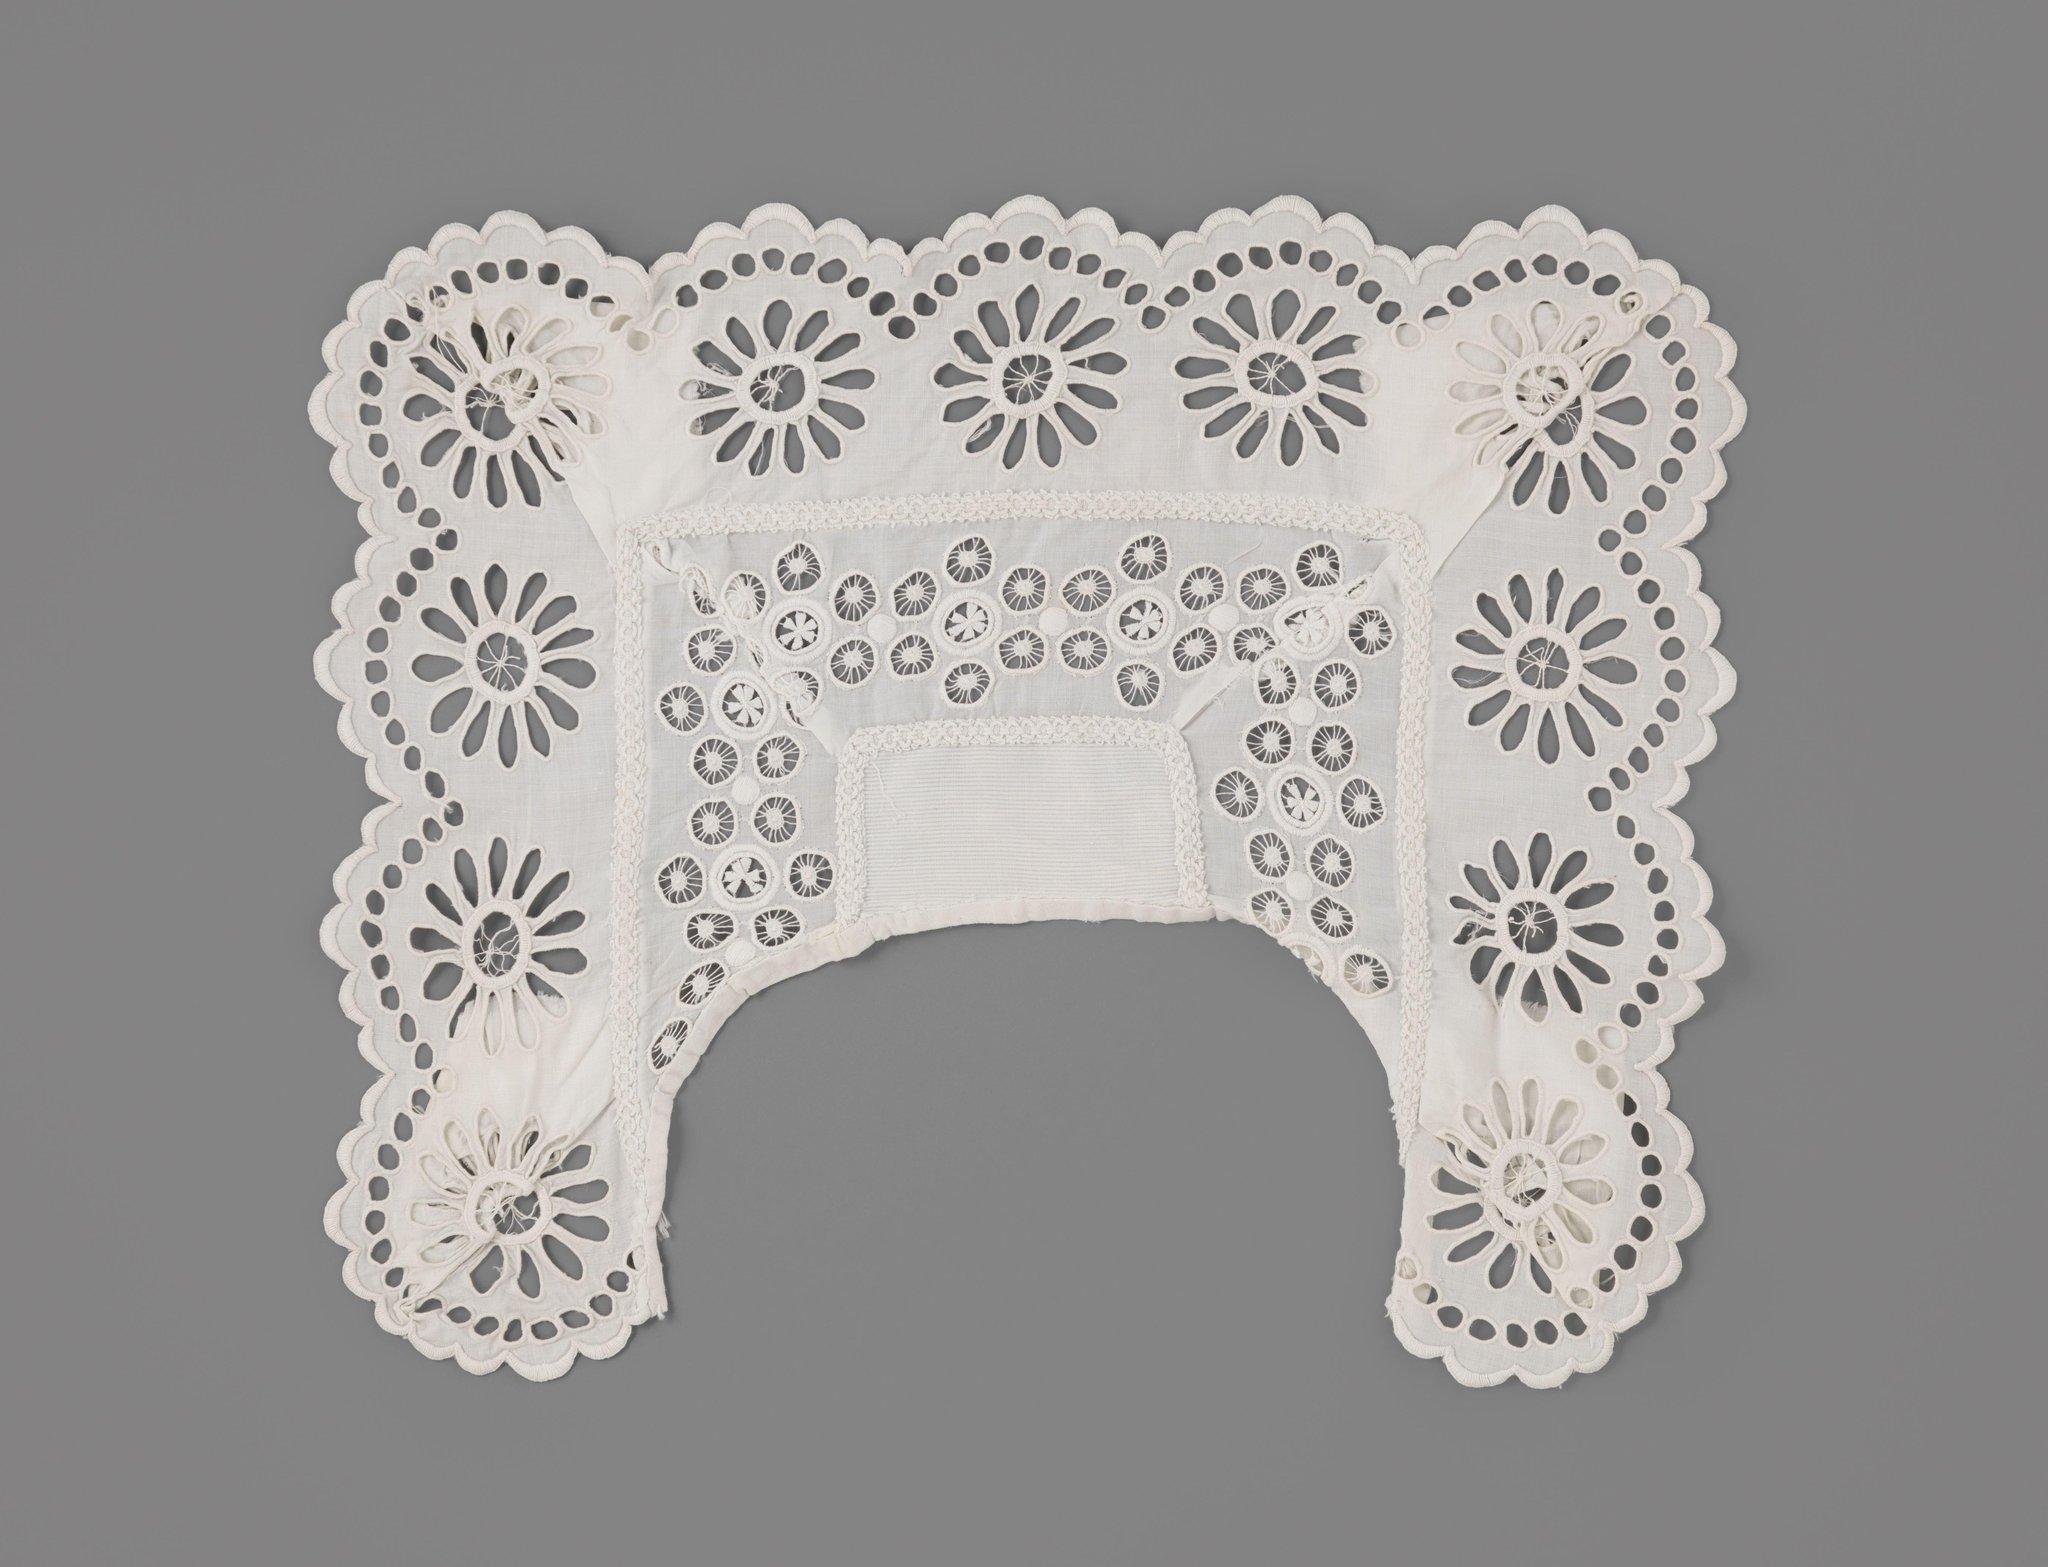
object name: collar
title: Kraag van batist versierd met Engels borduurwerk en naaldkant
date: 1875-1925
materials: textile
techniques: english embroidery, festoon stitch, needle lace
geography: western europe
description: Liggende, vierkante kraag van batist versierd met Engels borduurwerk en naaldkant. De kraag bestaat uit een rechthoek van geribbeld katoen dat is afgezet met een strook van batist versierd met cirkels van naaldkant. Hier is een strook van batist aan bevestigd die is versierd met Engels borduurwerk in de vorm van bloemen, en is afgezet met een gefestonneerde schulprand. De verschillende stroken worden van elkaar gescheiden door middel van sierband.